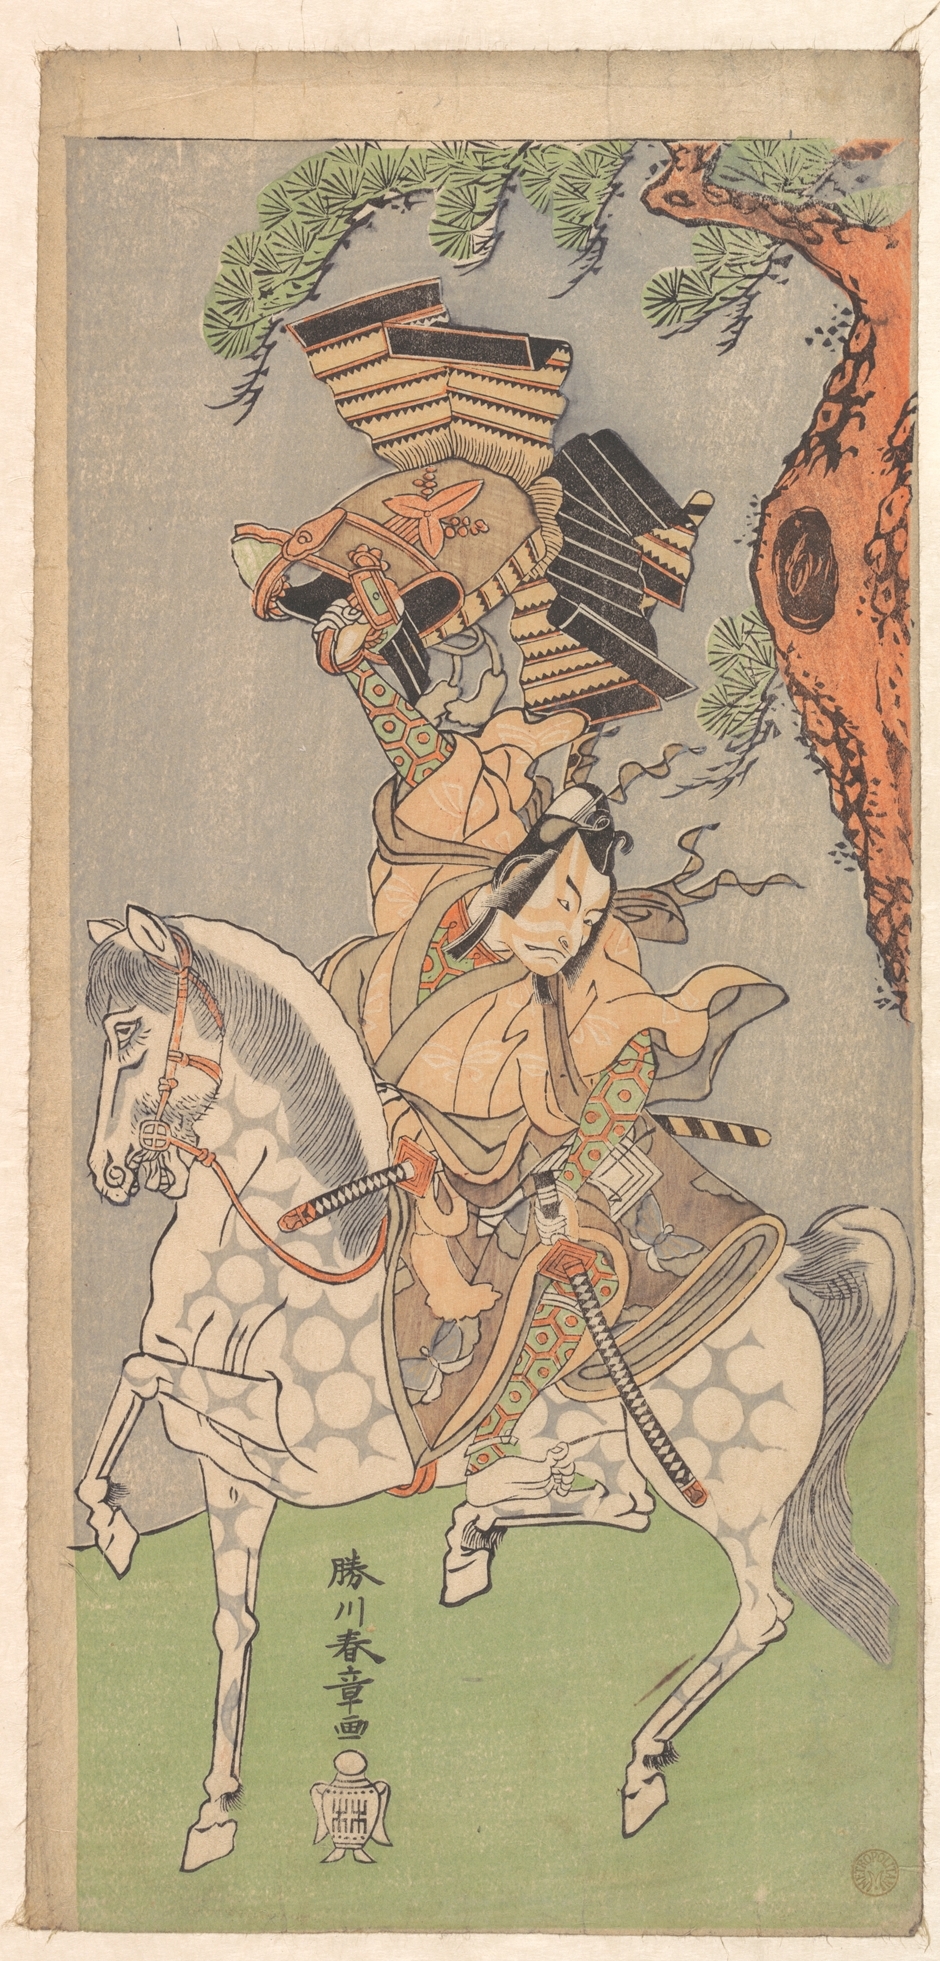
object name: woodblock print nishiki e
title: Ichikawa Danjuro V as a Warrior Mounted on a Dapple Gray Horse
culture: japanese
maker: katsukawa shunshō 勝川春章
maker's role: artist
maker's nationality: japanese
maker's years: 1726-1792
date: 1771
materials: ink, paper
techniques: nishiki e, woodblock print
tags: swords,horses,trees,actors